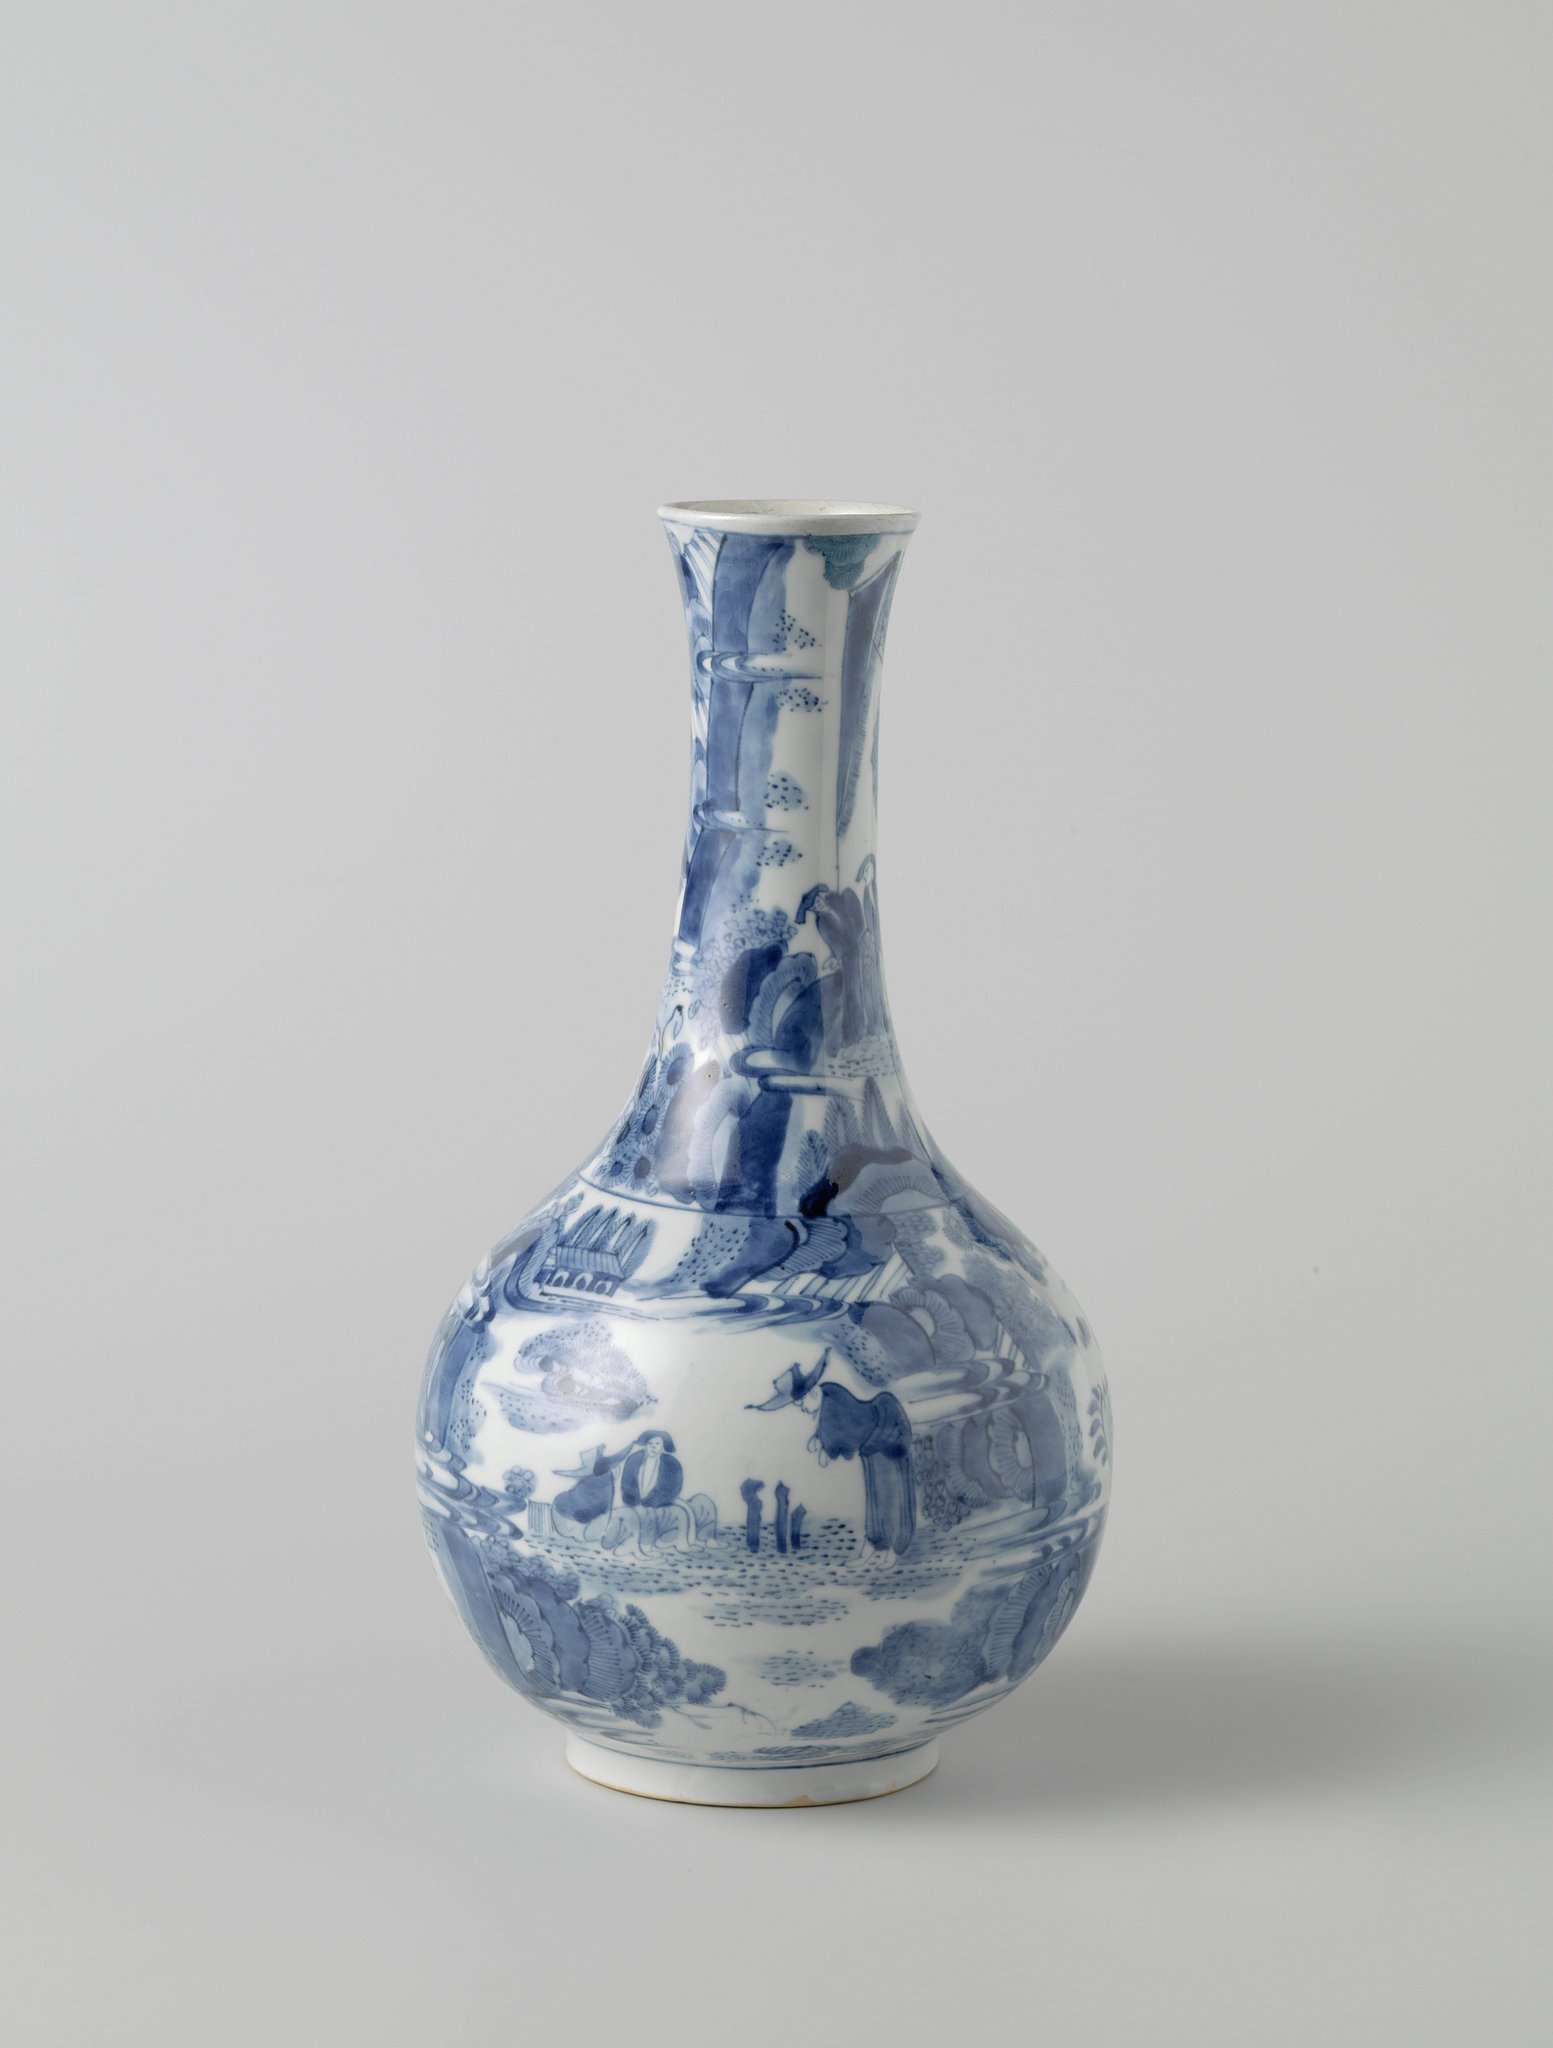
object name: bottle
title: Bottle vase with two continuous landscapes with figures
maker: Anonymous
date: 1650-1699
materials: cobalt, glaze, paint, porcelain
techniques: firing, turning, vitrification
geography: arita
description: Buikfles gedecoreerd in onderglazuur blauw met op de buik en hals figuren in een landschap.